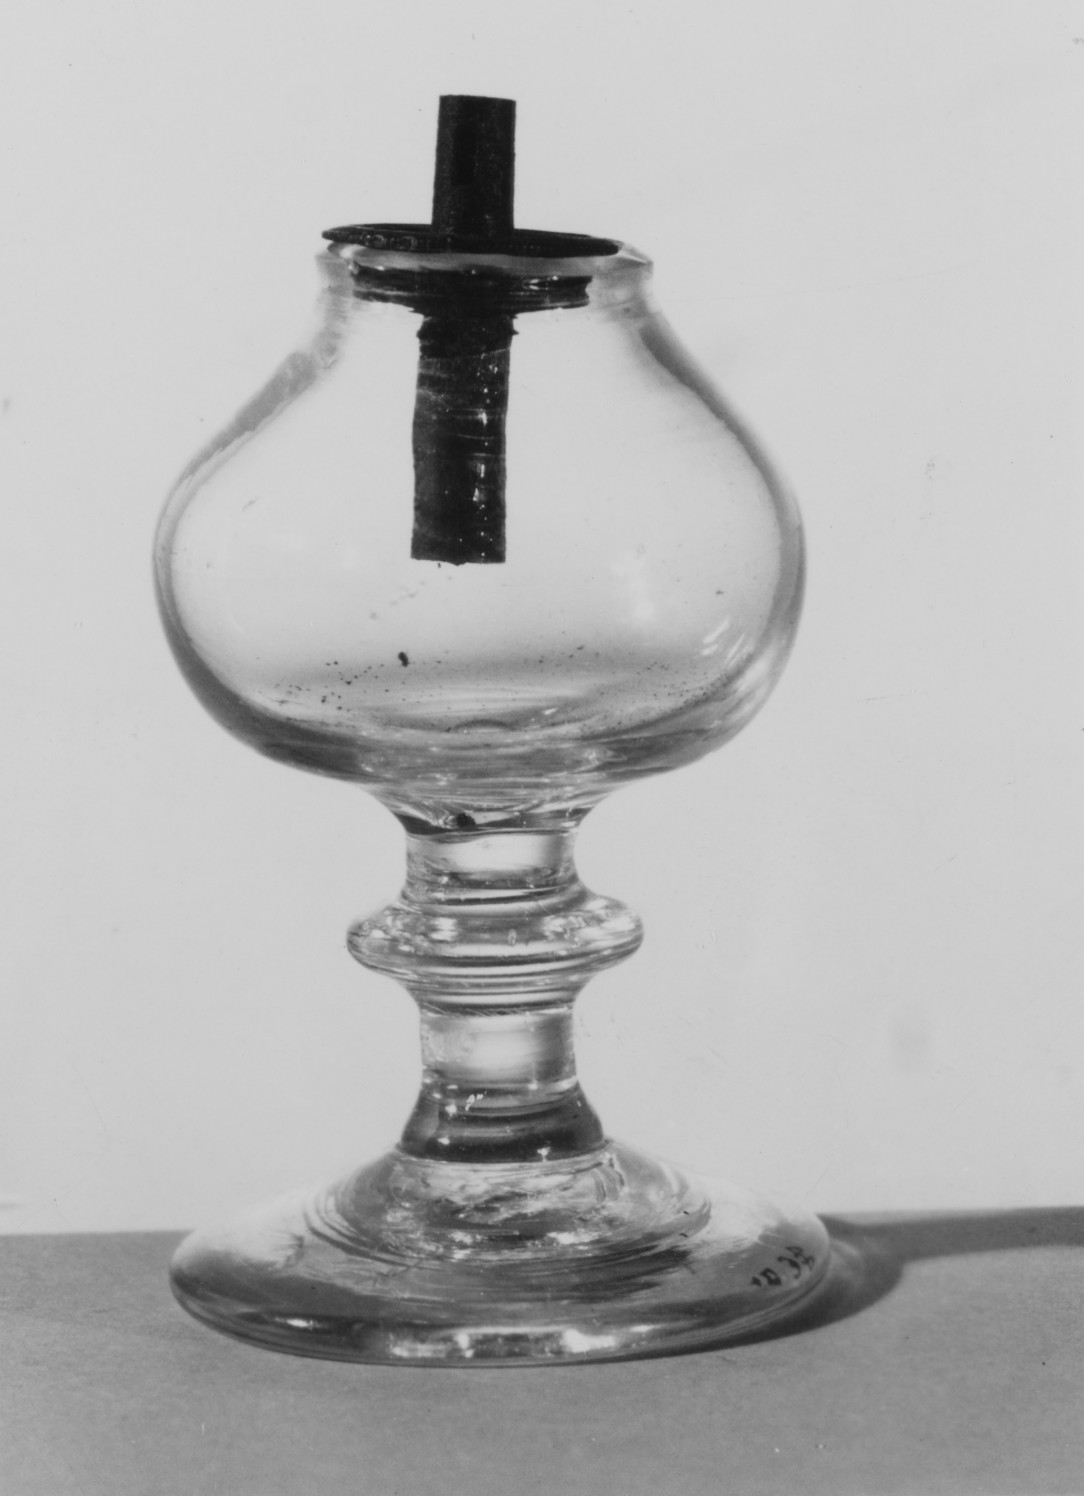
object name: lamp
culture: american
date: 1801-1900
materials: glass, lead, tin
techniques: glassblowing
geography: united states